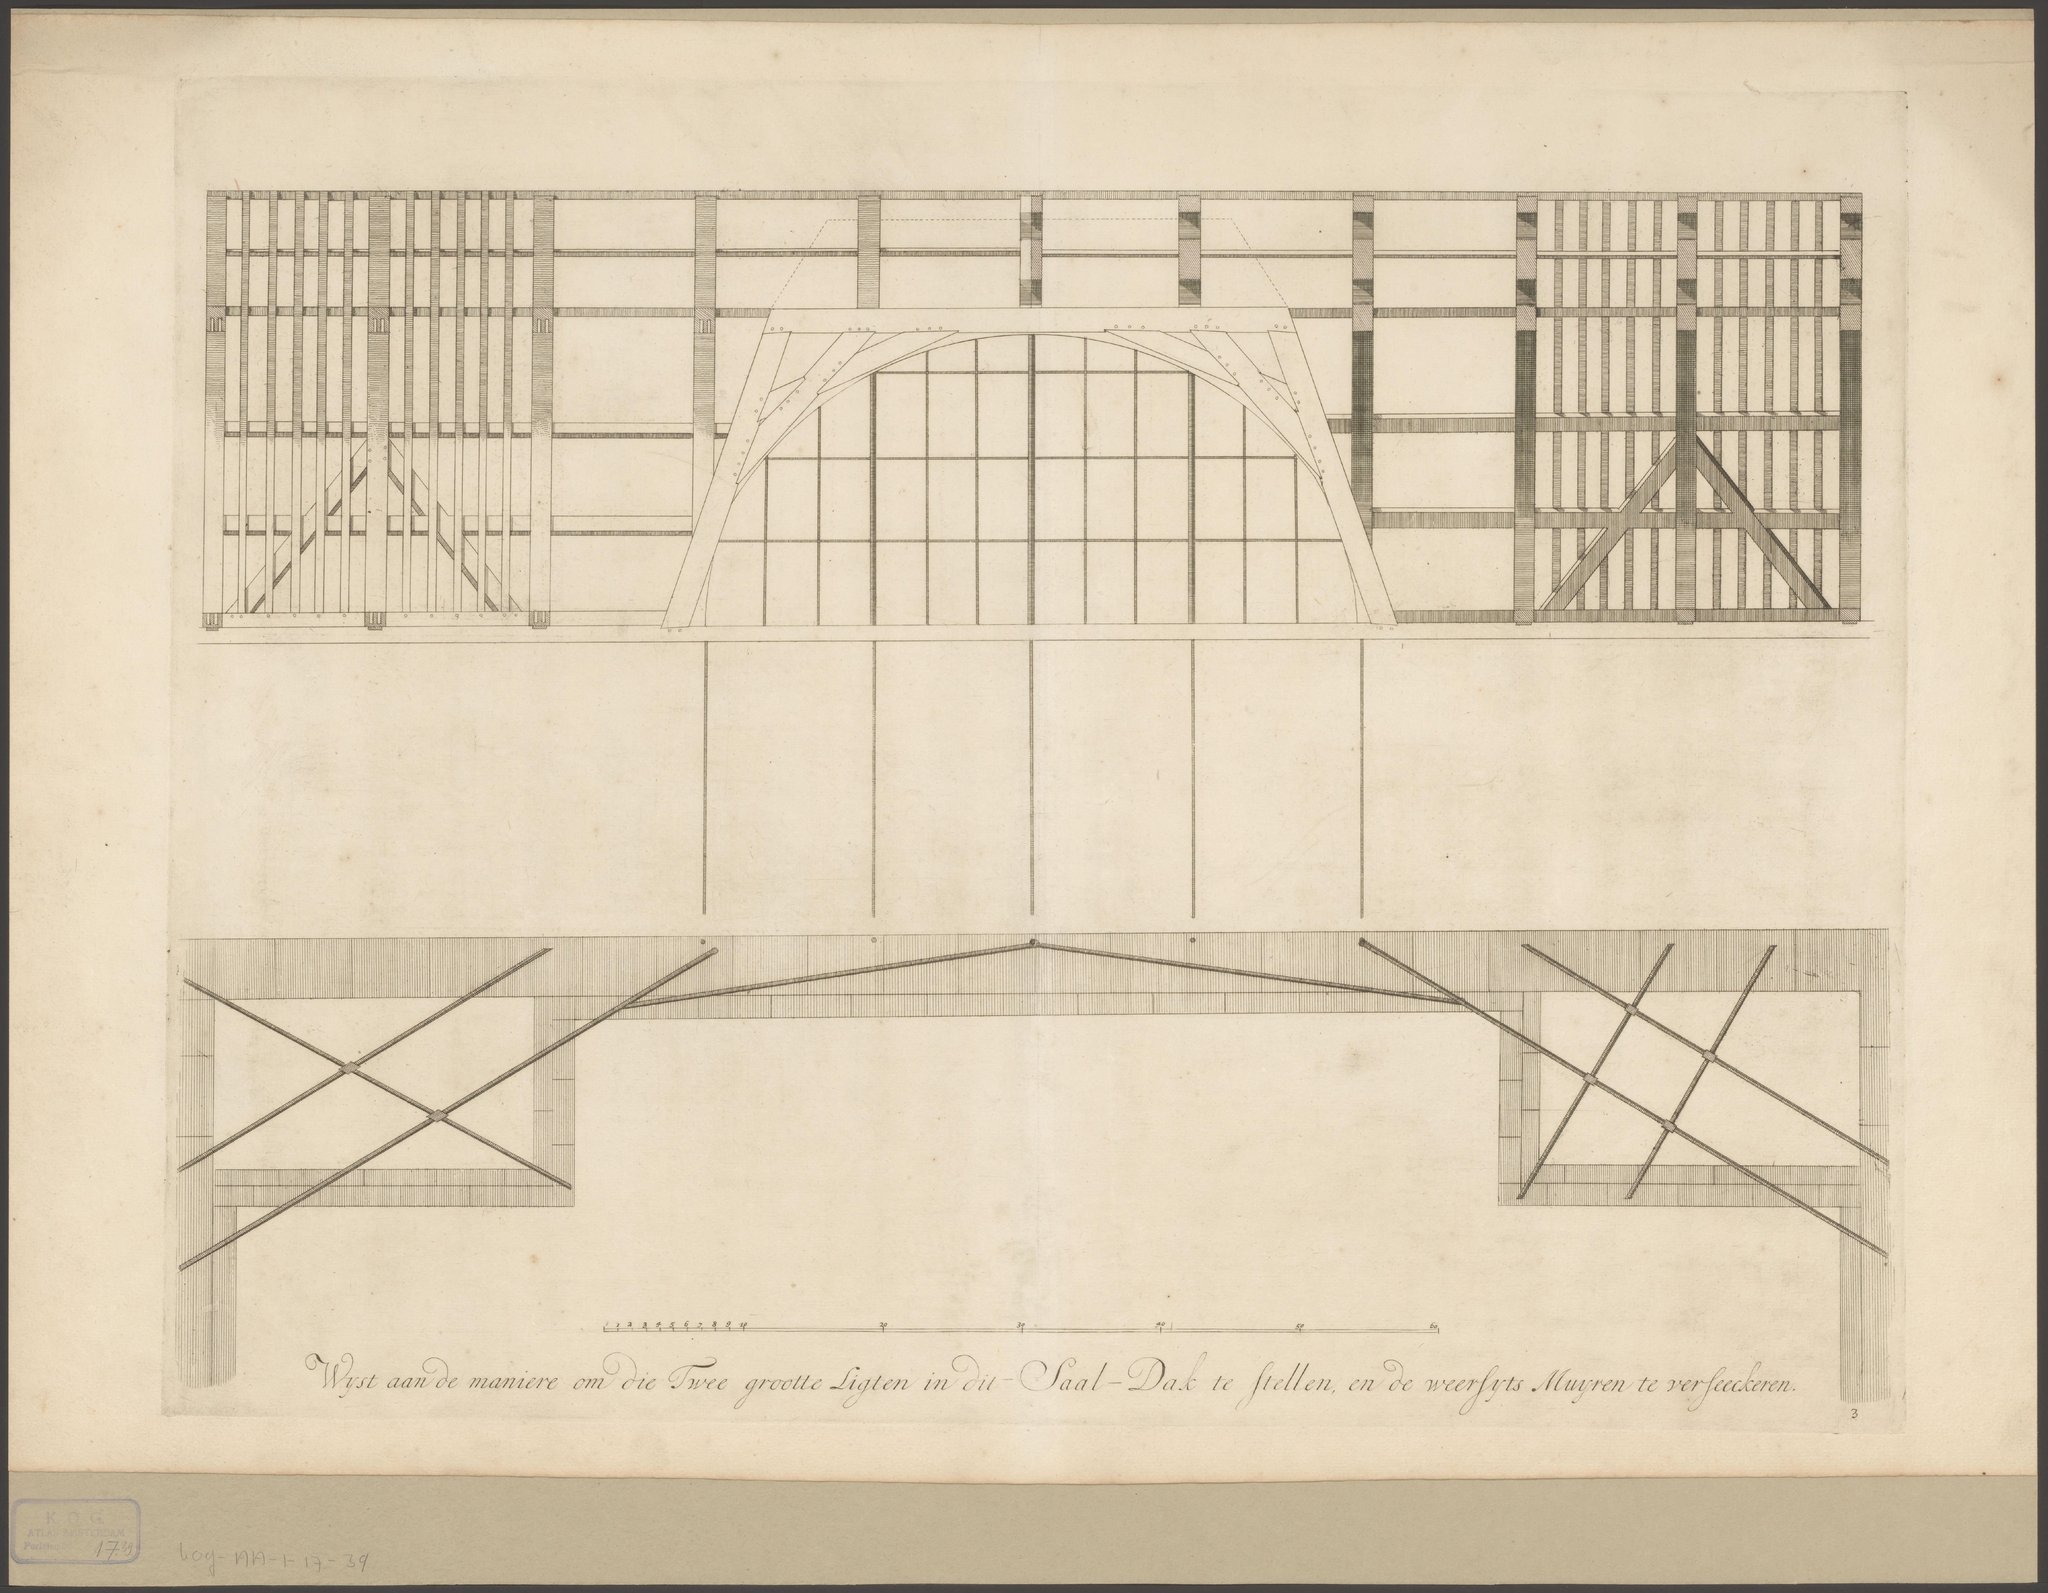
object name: print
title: Ontwerp voor de constructie van het dak van de Burgerzaal in het Stadhuis op de Dam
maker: Anonymous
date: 1600-1650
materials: paper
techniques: engraving, etching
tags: roof (of house or building), townhall, plan ~ architecture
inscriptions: collector's mark: ‘17.39’ Lugt 1641b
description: Onderwerpsrubriek binnen de Atlas Amsterdam: Nieuwe Stadhuis, van binnen: Kap, Plattegronden, Betimmering. Genummerd rechtsonder: 3.